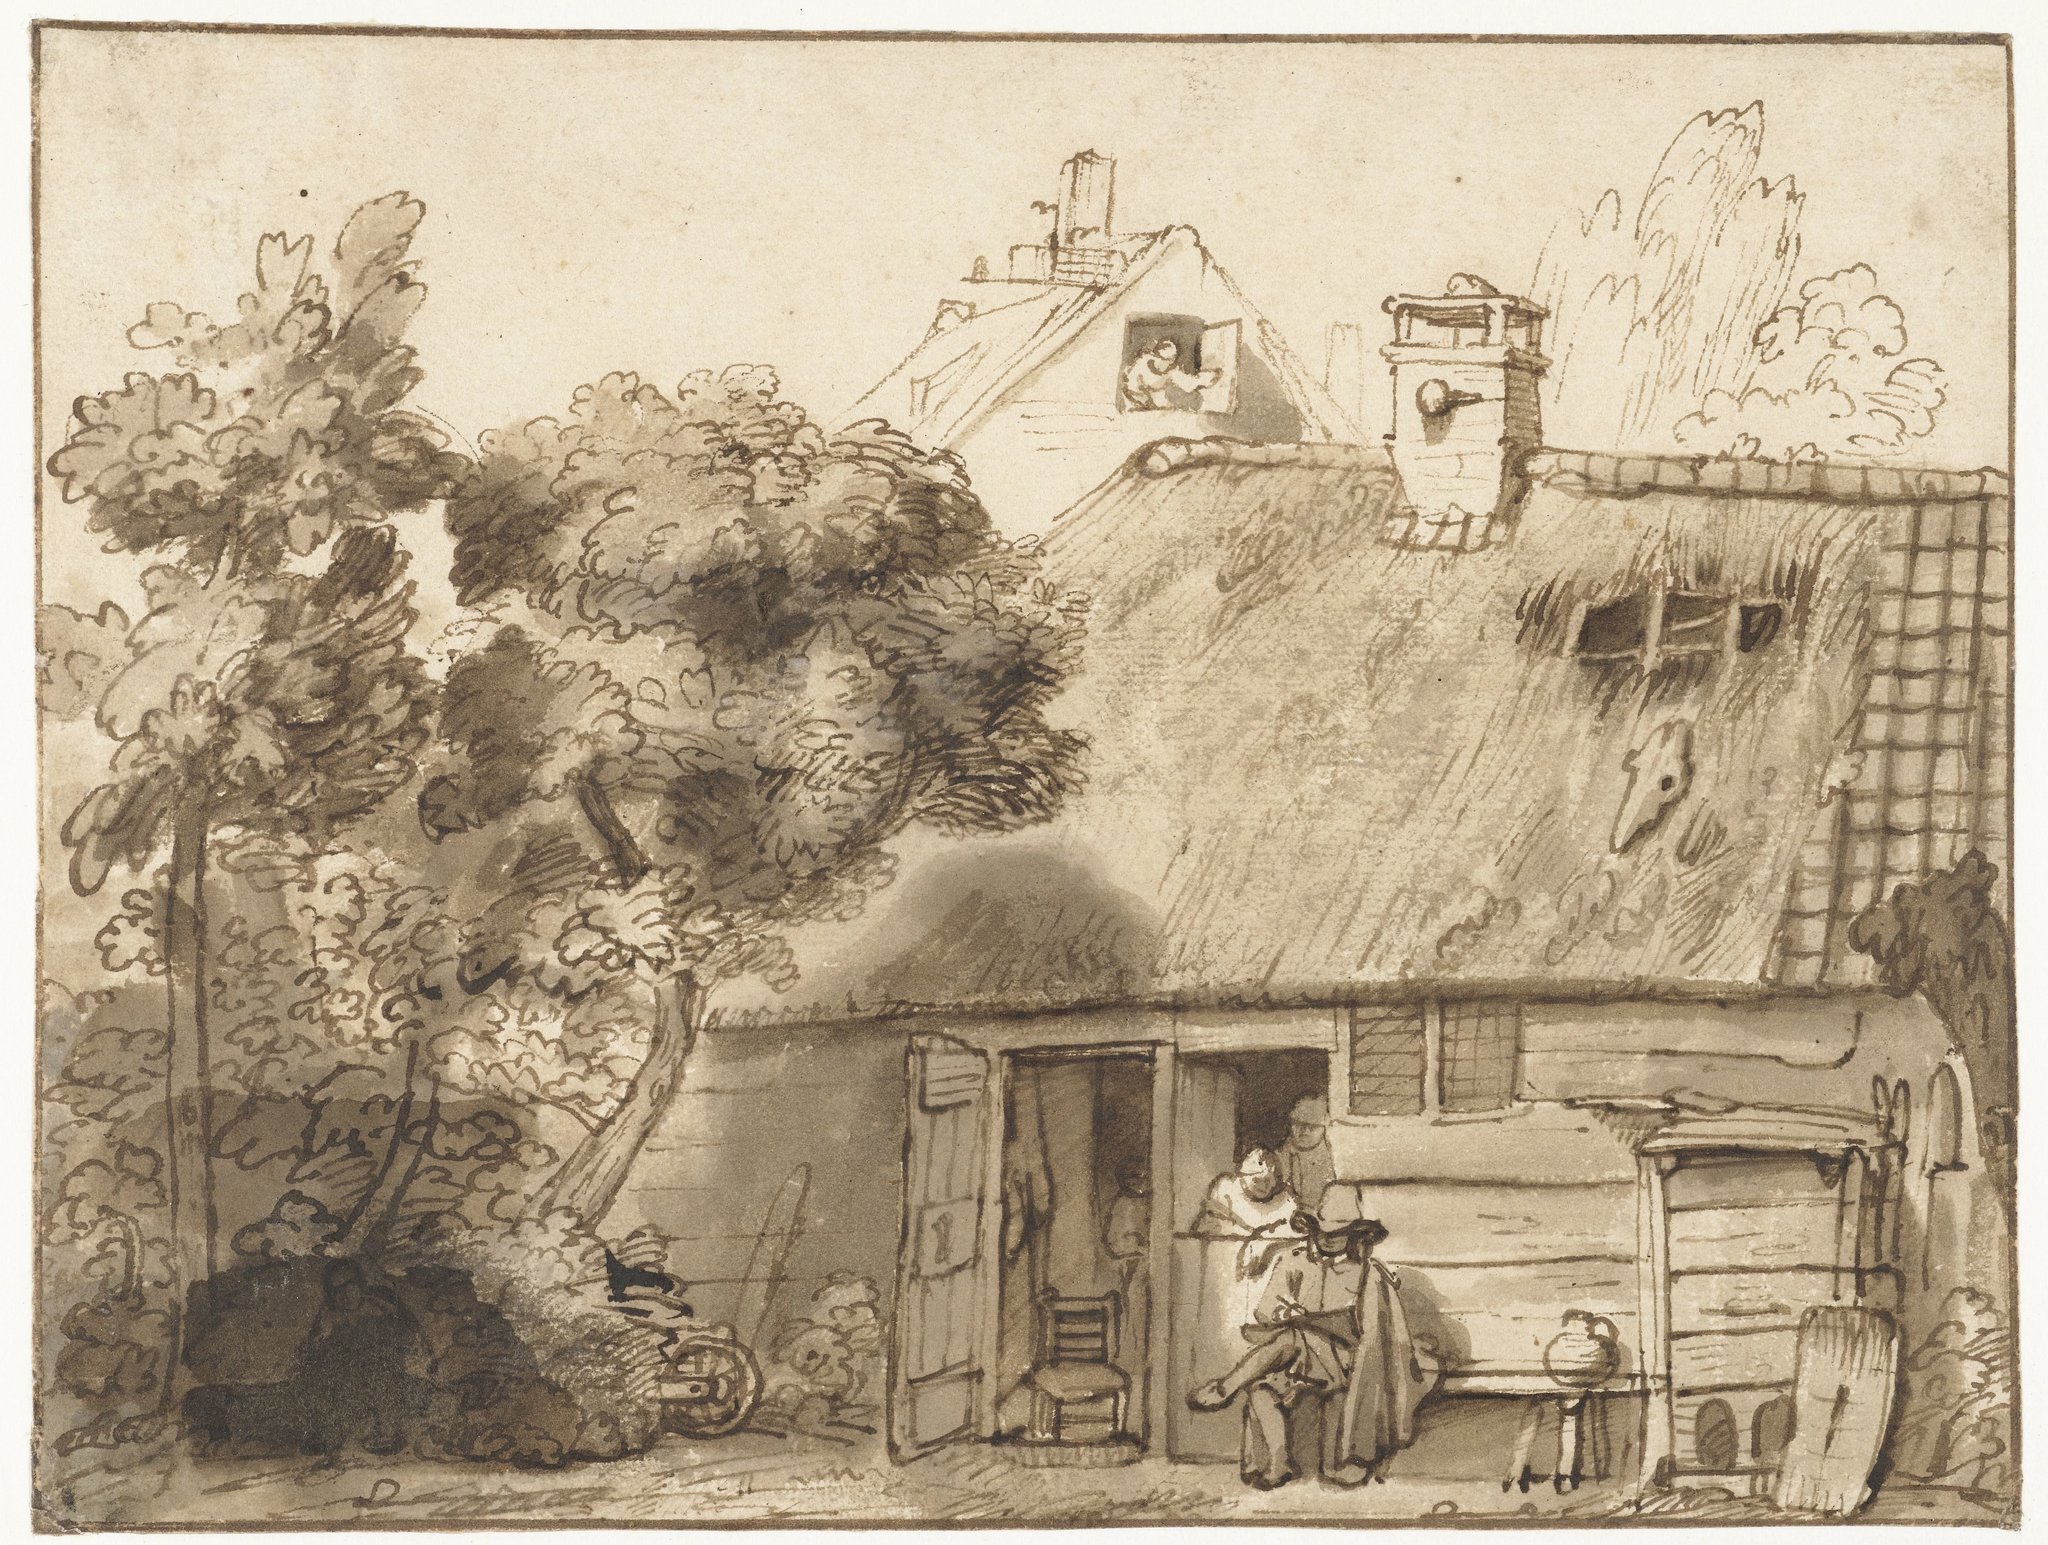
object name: drawing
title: Houten huis en tekenaar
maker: abraham furnerius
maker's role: draughtsman, painter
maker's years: 1628-1654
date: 1638-1654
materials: ink, paper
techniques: brush, pen